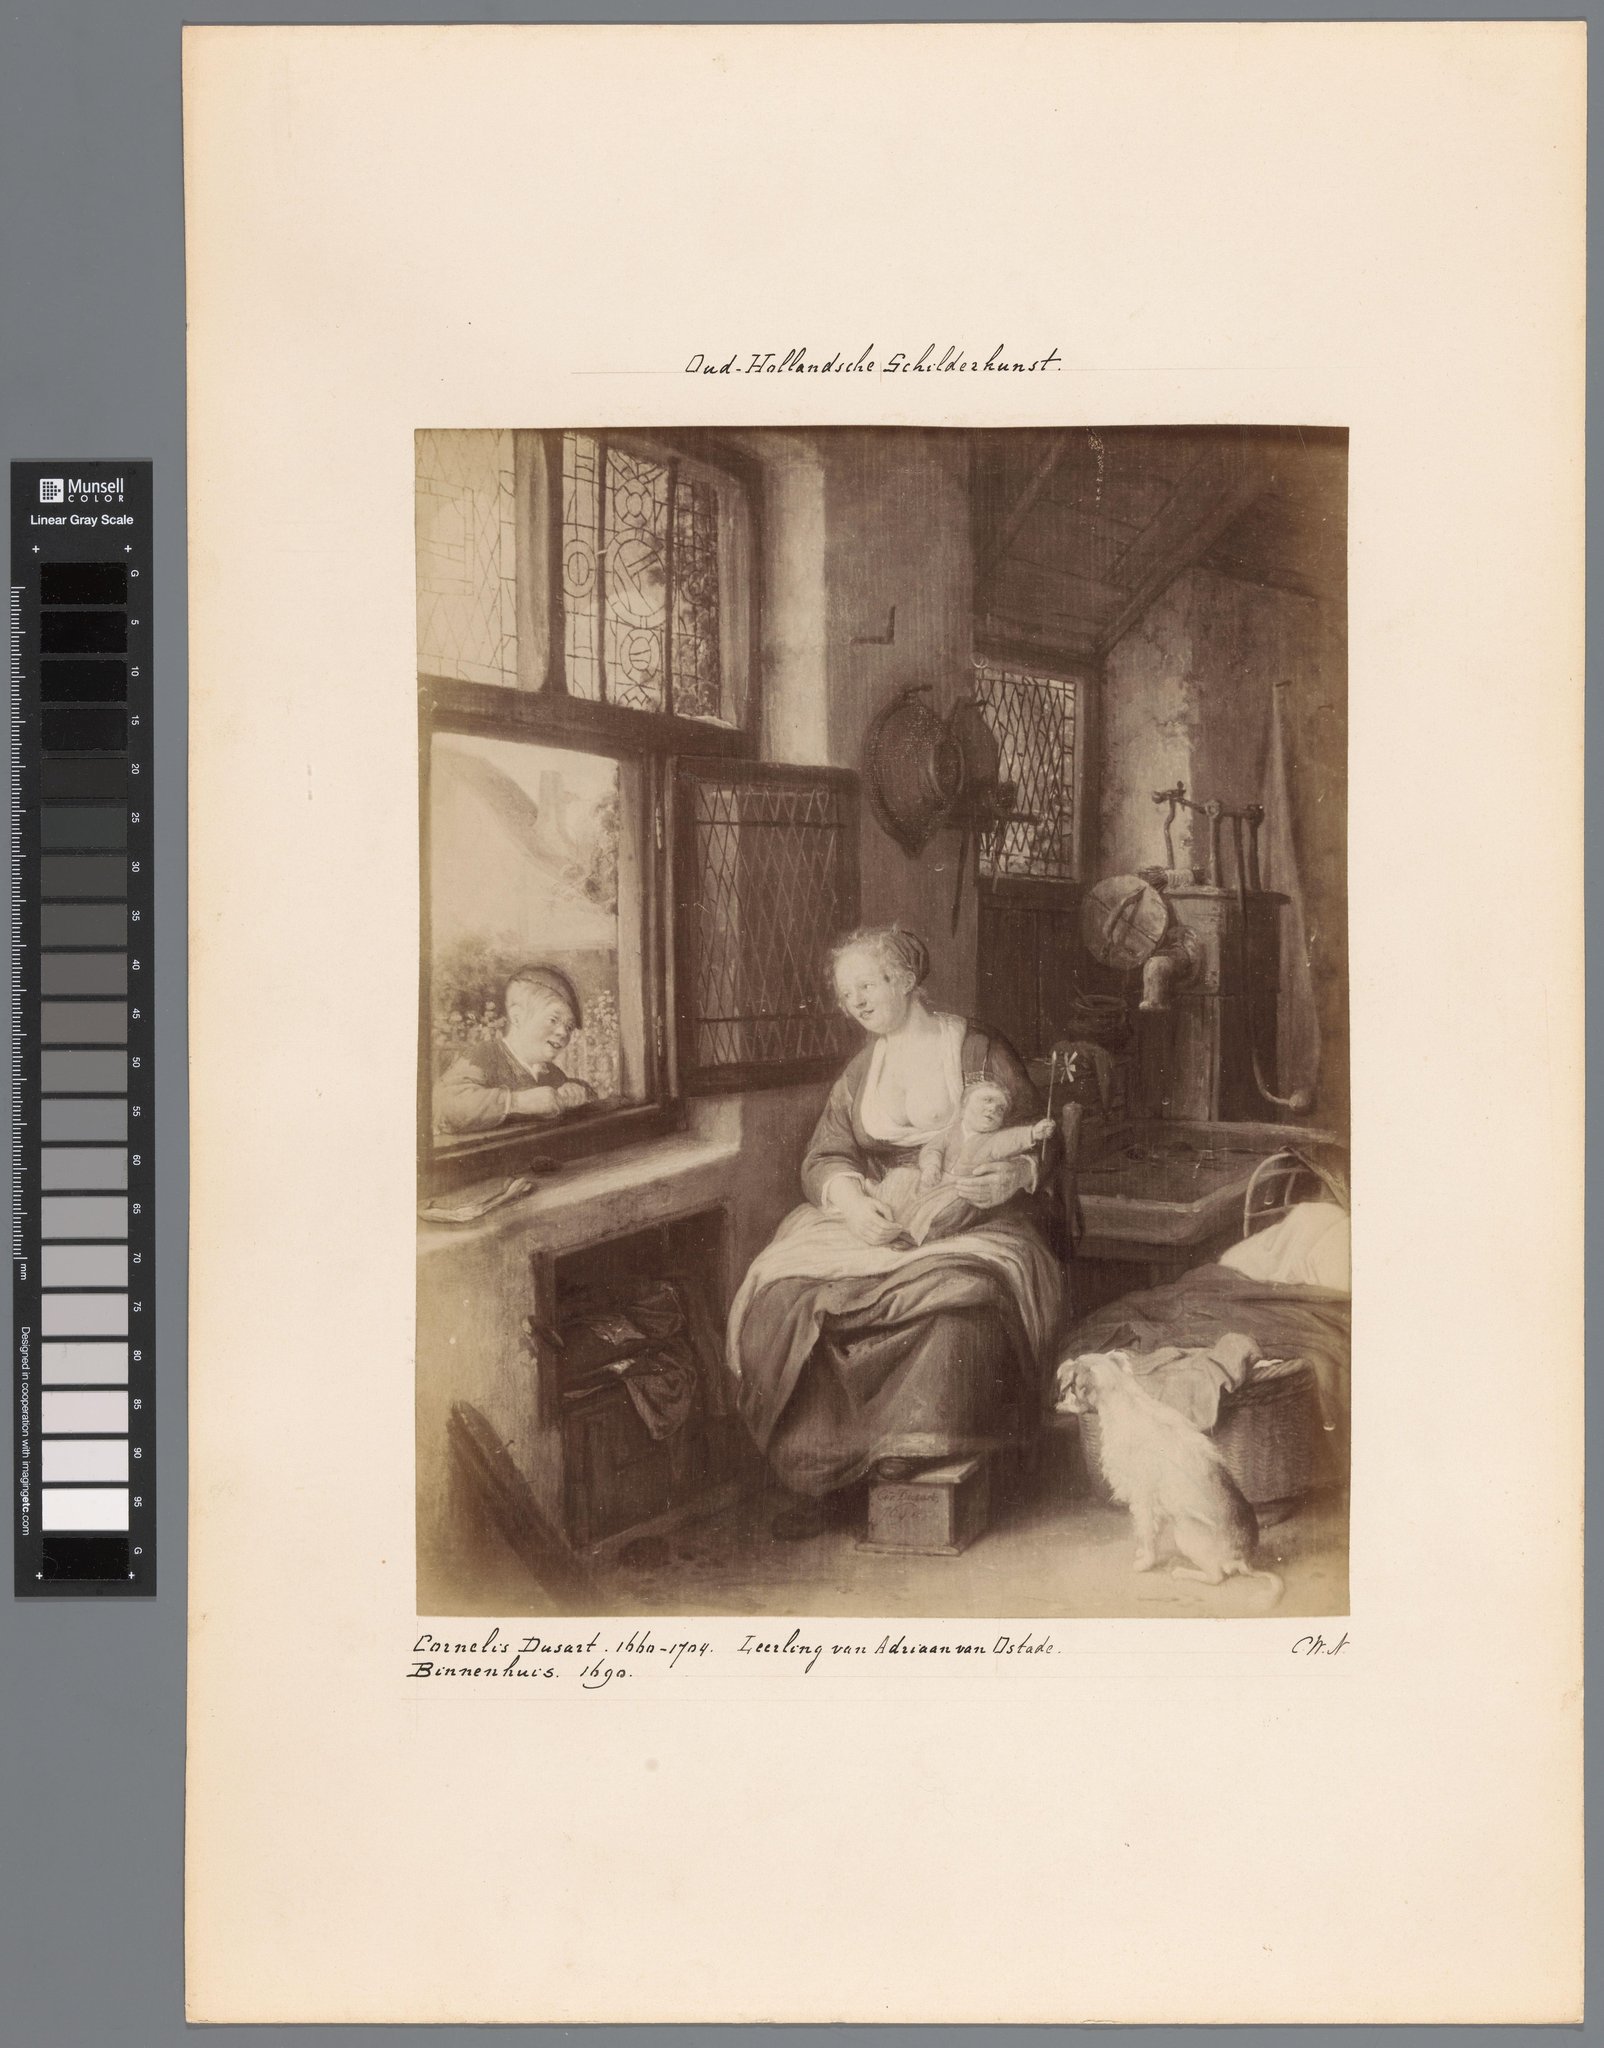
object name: photograph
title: Fotoreproductie van een schilderij door Cornelis Bisschop, voorstellende een interieur met een vrouw en kind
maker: Anonymous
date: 1875-1900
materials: cardboard, photographic support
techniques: albumen print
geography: netherlands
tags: adult woman, interior of the house, infant, baby, dog, netherlands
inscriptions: name: ‘CWN.’, inscription: ‘Oud-Hollandsche Schilderkunst. Cornelis Bisschop. (...) Binnenhuis. 1690.’, collector's mark: ‘KUNSTNIJVERHEIDSCHOOL QUELLINUS AMSTERDAM FRANS HALSSTRAAT 14.’, collector's mark: ‘INSTITUUT VOOR KUNST- NIJVERHEIDSONDERWIJS GABRIËL METSUSTRAAT No. 16. AMSTERDAM’